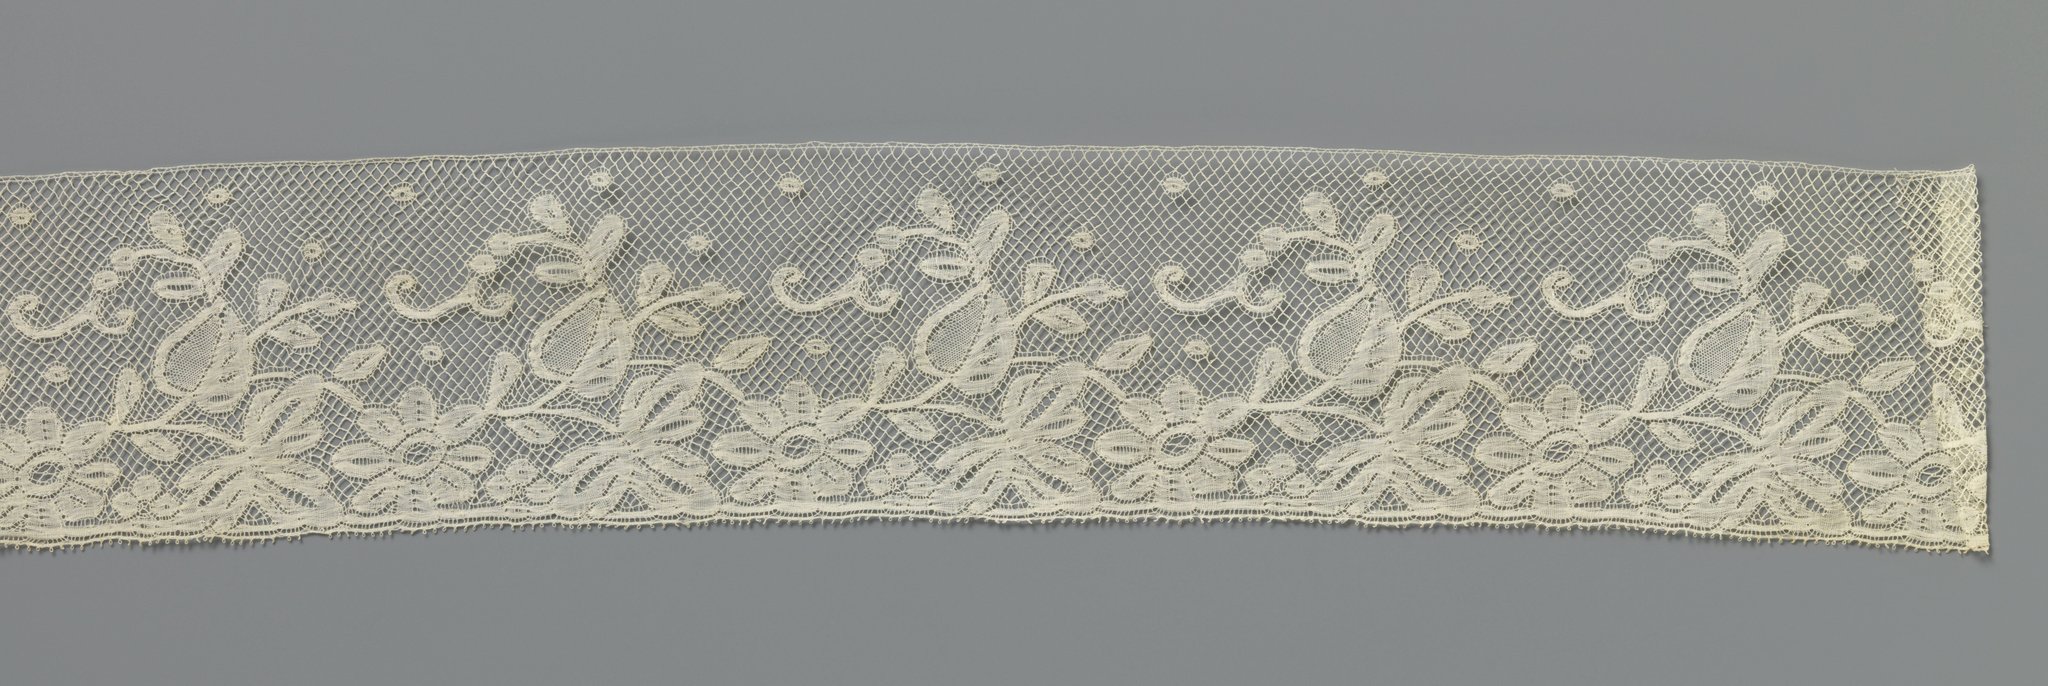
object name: strip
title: Strook kloskant met rozetbloem tussen hartvormige bladeren en wijnbladeren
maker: Anonymous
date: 1900-1915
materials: cotton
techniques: lace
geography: belgium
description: Strook naturelkleurige kloskant, Valenciennes-kant. Het zich herhalende en doorlopende patroon bestaat uit een rozetbloem tussen hartvormige bladeren en wijnbladeren. De motieven zijn met elkaar verbonden door een maasgrond, een ruitvormige Valenciennes-grond, bezaaid met moesjes. De motieven zijn gemaakt in linnenslag met uitsparingen en opengewerkte randjes. Eén helft van het hartvormige blad is gemaakt in netslag. Het bloemhart is versierd met een ringetje tussen vier vlechtjes. De uitsparingen in de bloemblaadjes zijn versierd met overstekende paren. Boven- en onderzijde van de strook zijn recht afgewerkt, waarbij de onderzijde is voorzien van picots.